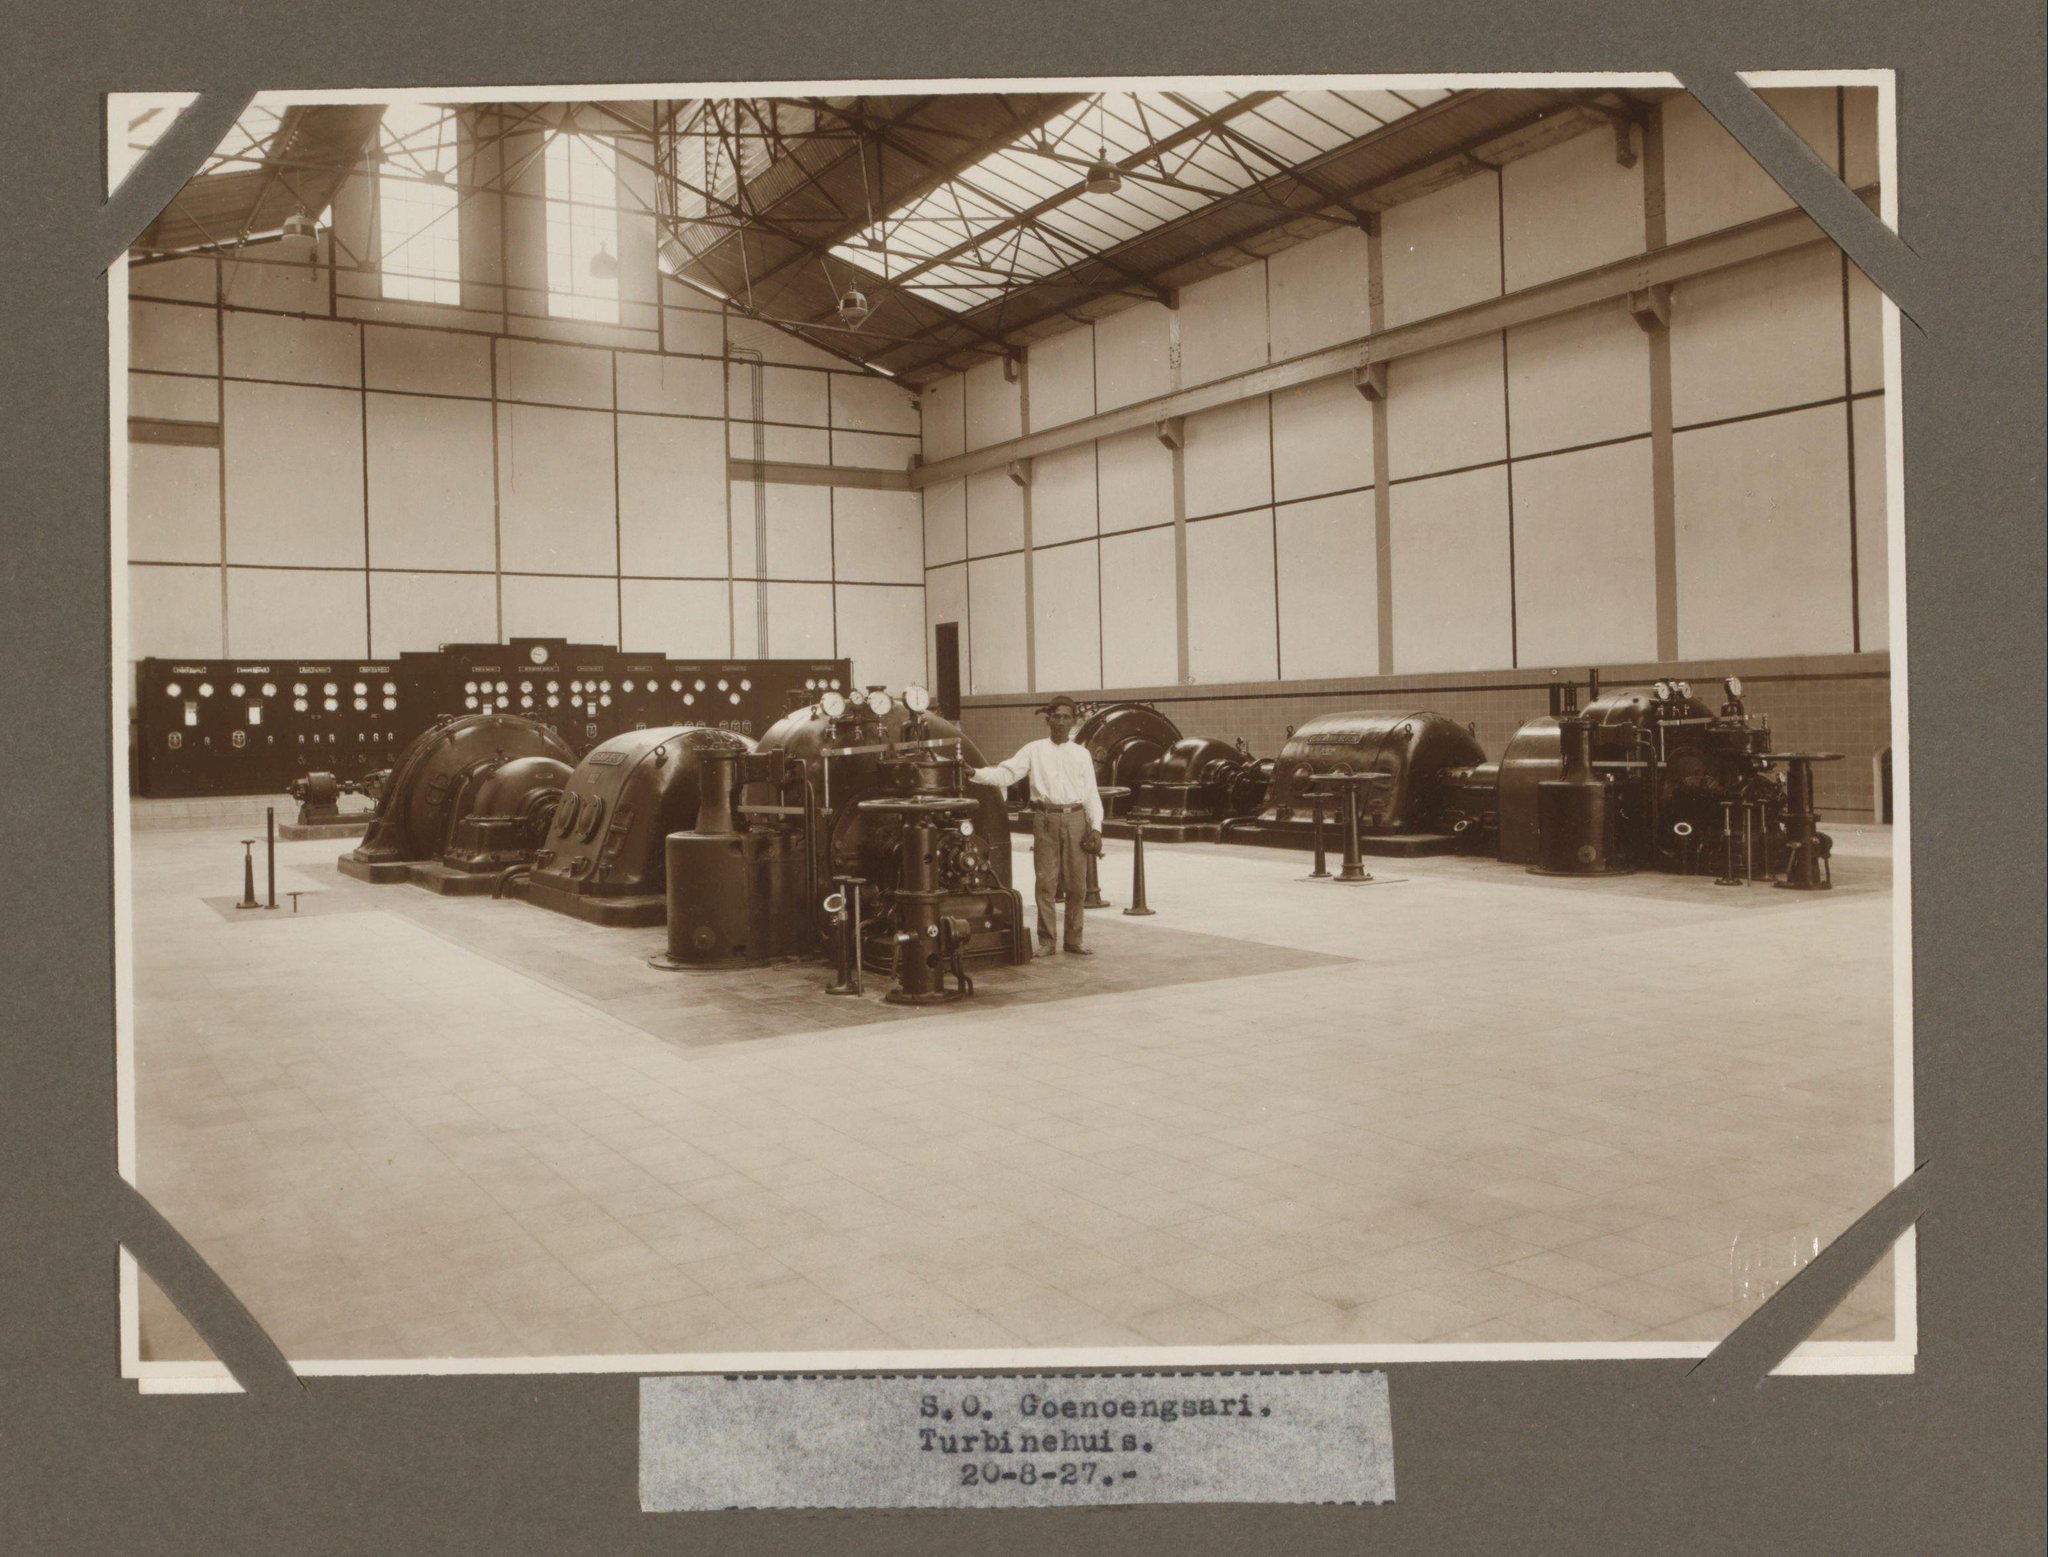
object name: photograph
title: S.O. Goenoengsari. Turbinehuis. 20-8-27.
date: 1908-1927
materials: photographic support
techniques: gelatin silver print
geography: surabaya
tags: colonial system, trade-company, factory-interior, machine shop, making the overground structures (~ building activities), (non-fruit) products of plants or trees: sugarcane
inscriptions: company name: ‘"ISKEN" Soerabaia’, inscription: ‘S.O. Goenoengsari. Turbinehuis. 20-8-27.’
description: Fabriekshal met installaties. Bouw voltooid, eind augustus 1927. Met een Javaanse werknemer staande bij de voorste turbine. Onderdeel van het fotoalbum met foto's van de opbouw van de suikerfabriek te Goenoengsari op Oost-Java door de Handels Vereniging Amsterdam 1926-1927.